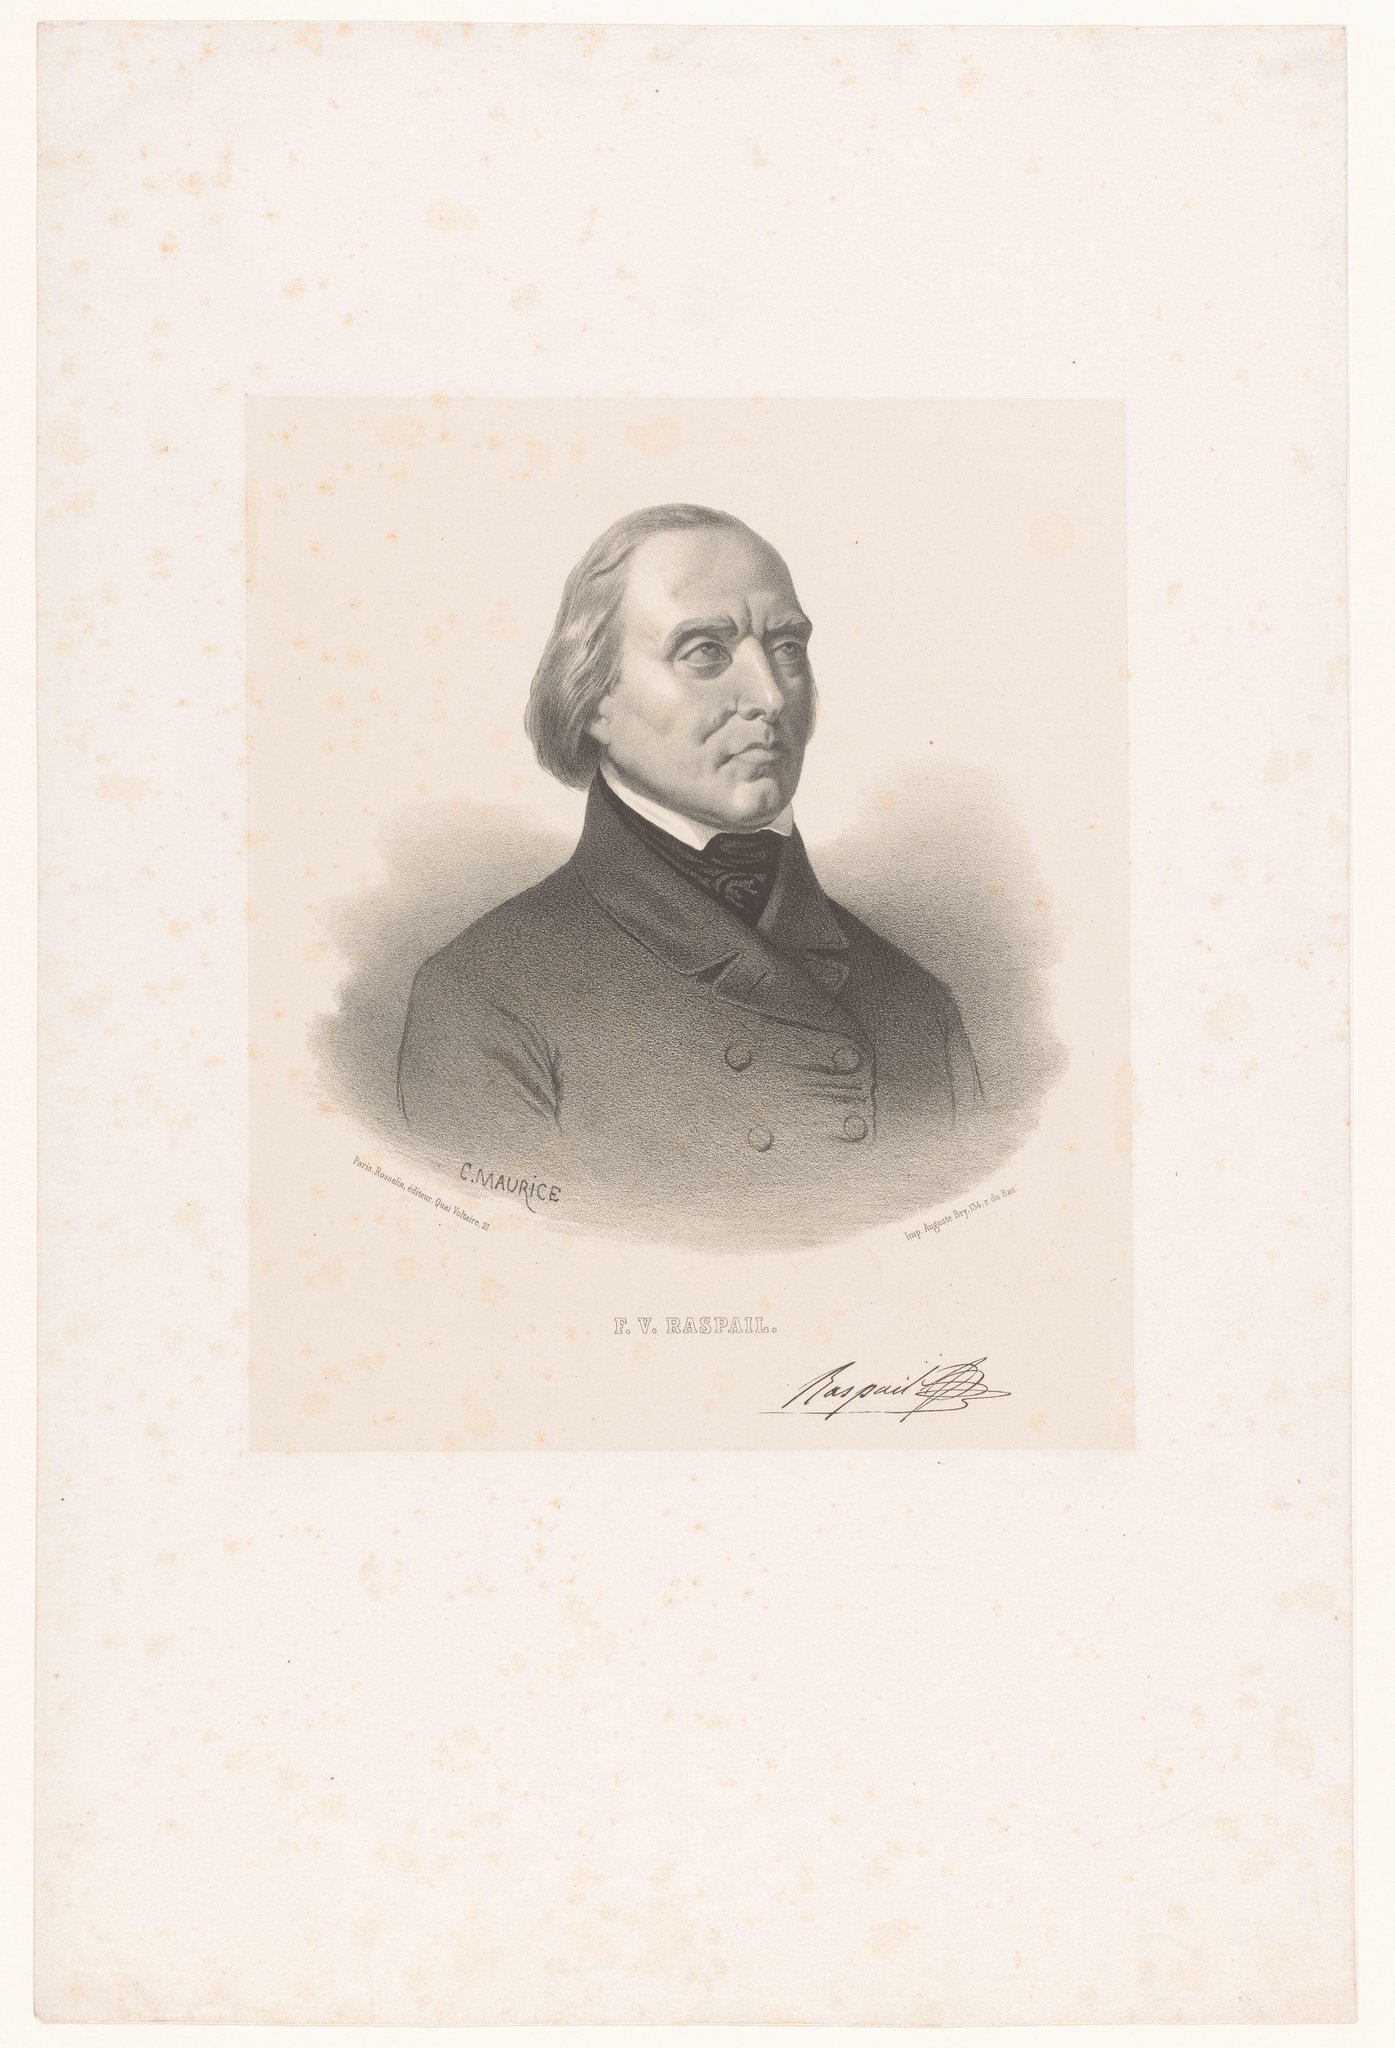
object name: print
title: Portret van François-Vincent Raspail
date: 1830-1861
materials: paper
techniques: lithograph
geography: paris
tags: politician, historical persons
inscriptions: collector's mark: Lugt 2228